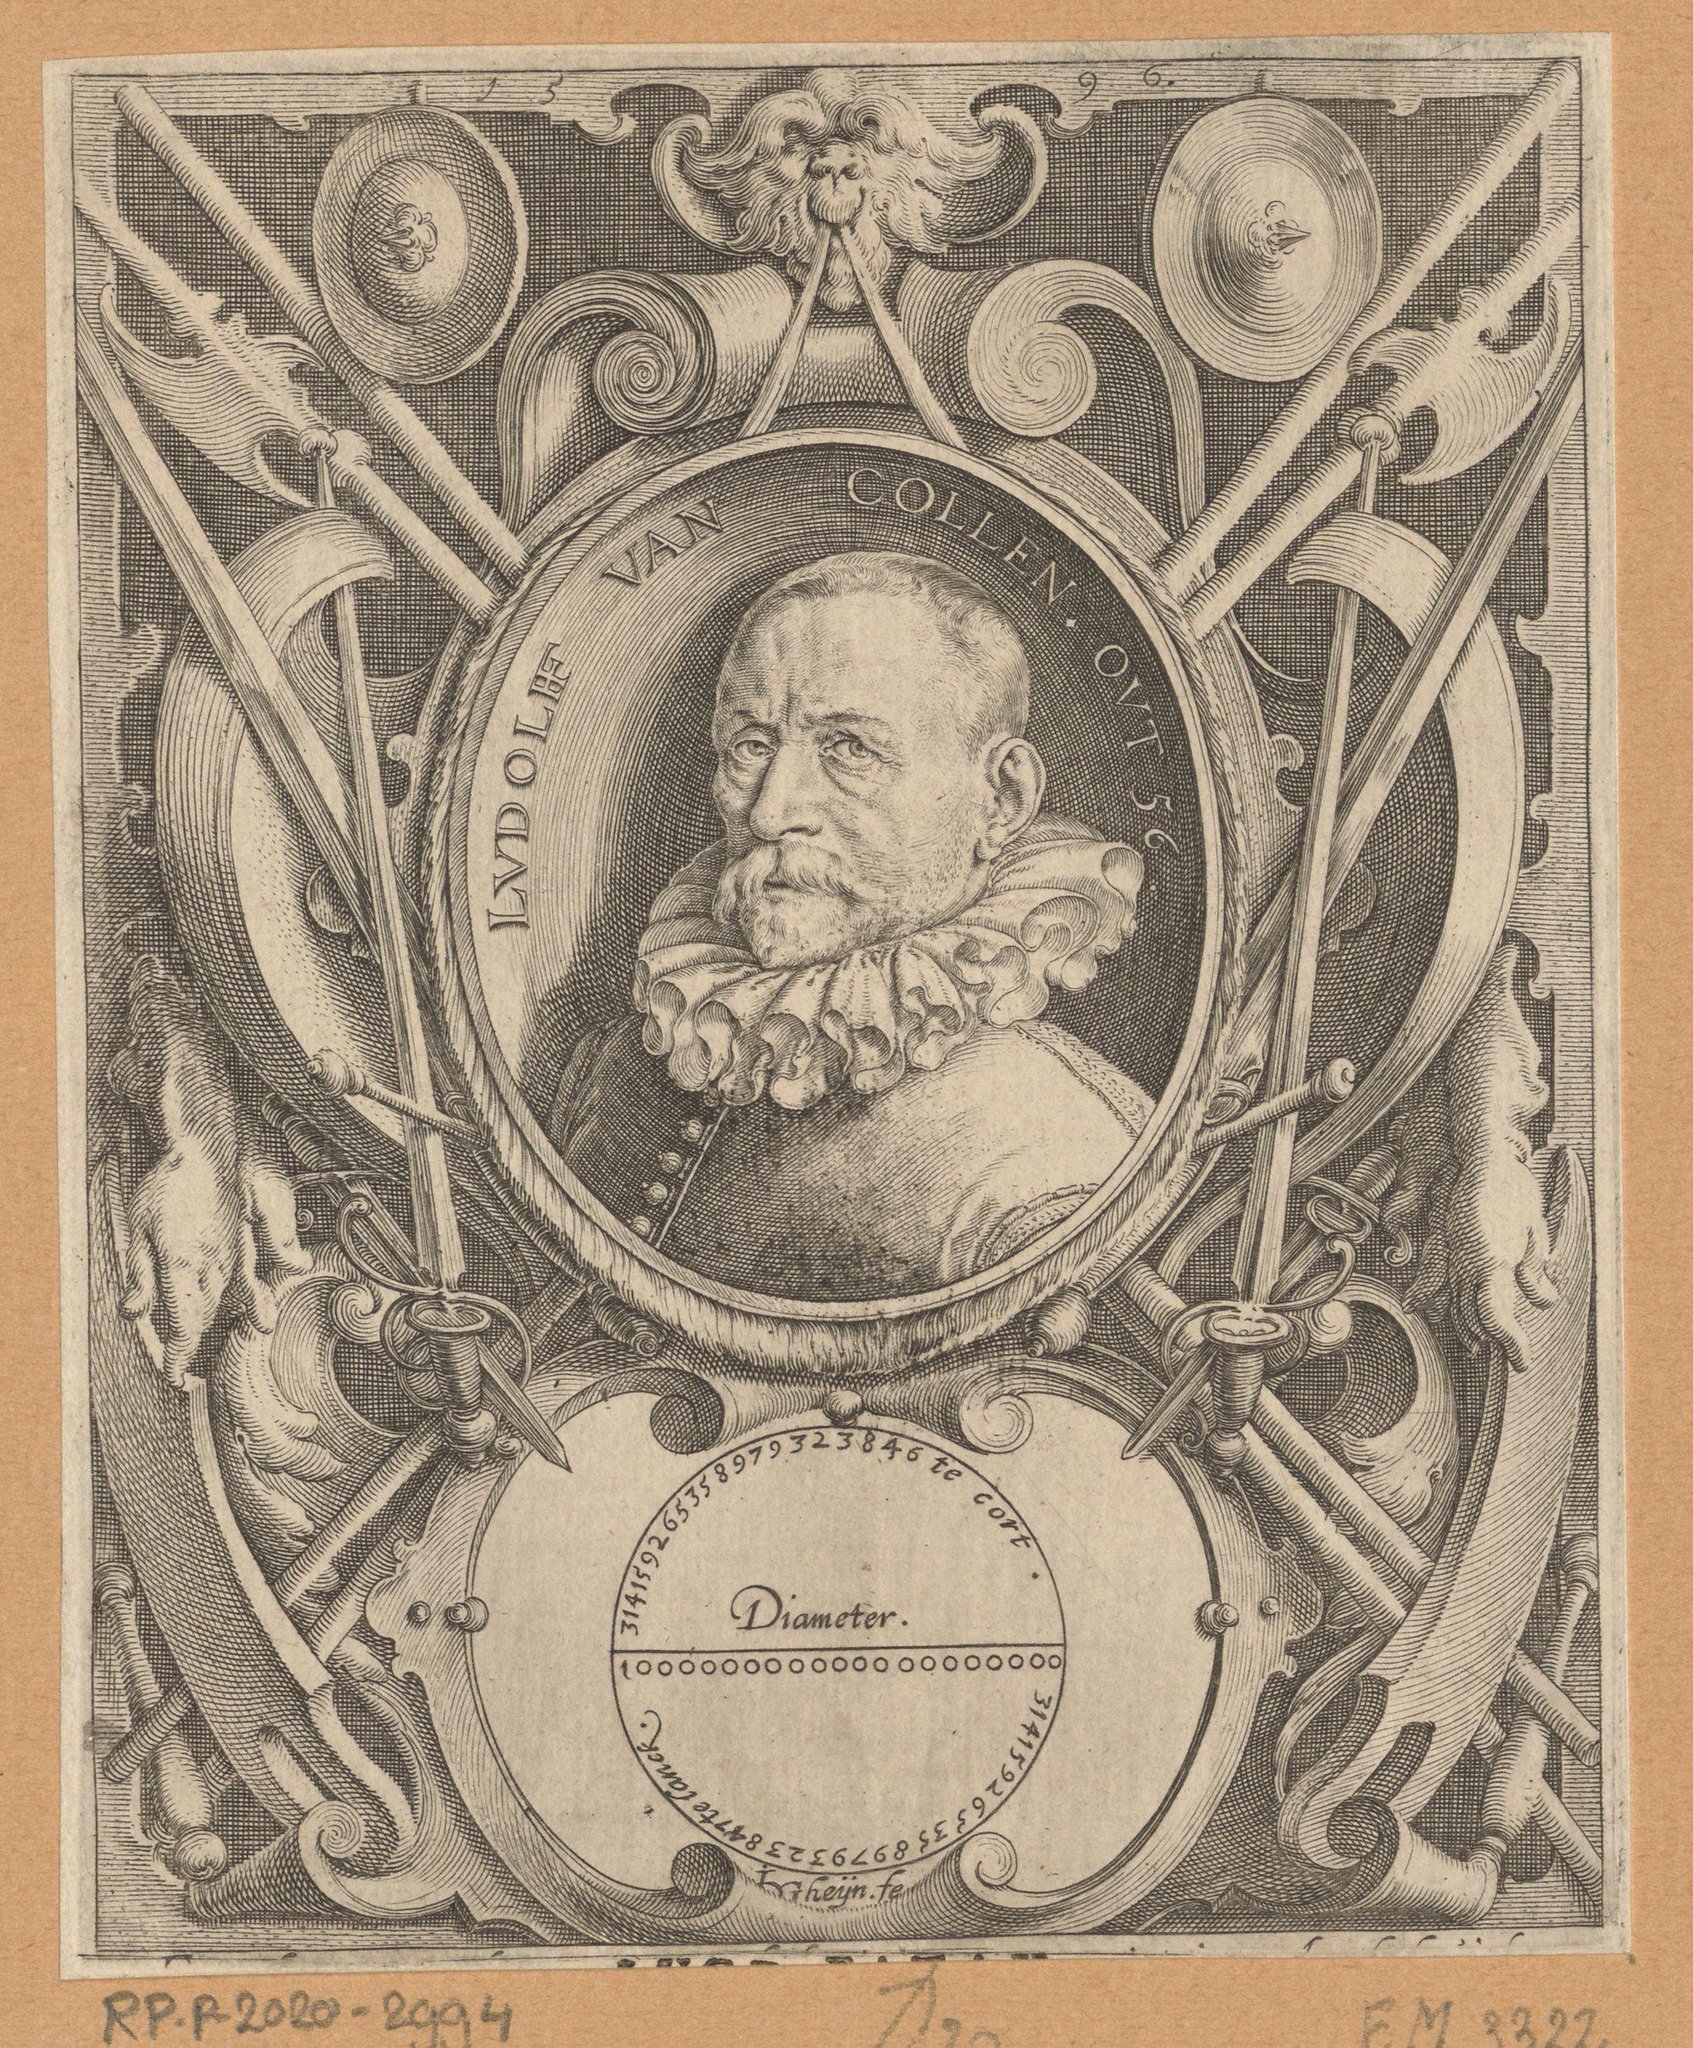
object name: book illustration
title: Portret van Ludolph van Ceulen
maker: jacques de gheyn (ii)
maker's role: painter, print maker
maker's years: 1565-1629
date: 1630-1699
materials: paper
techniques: engraving, letterpress printing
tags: leiden, historical persons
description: Onder het portret een afbeelding van een cirkel met een beschrijving van het getal Phi.